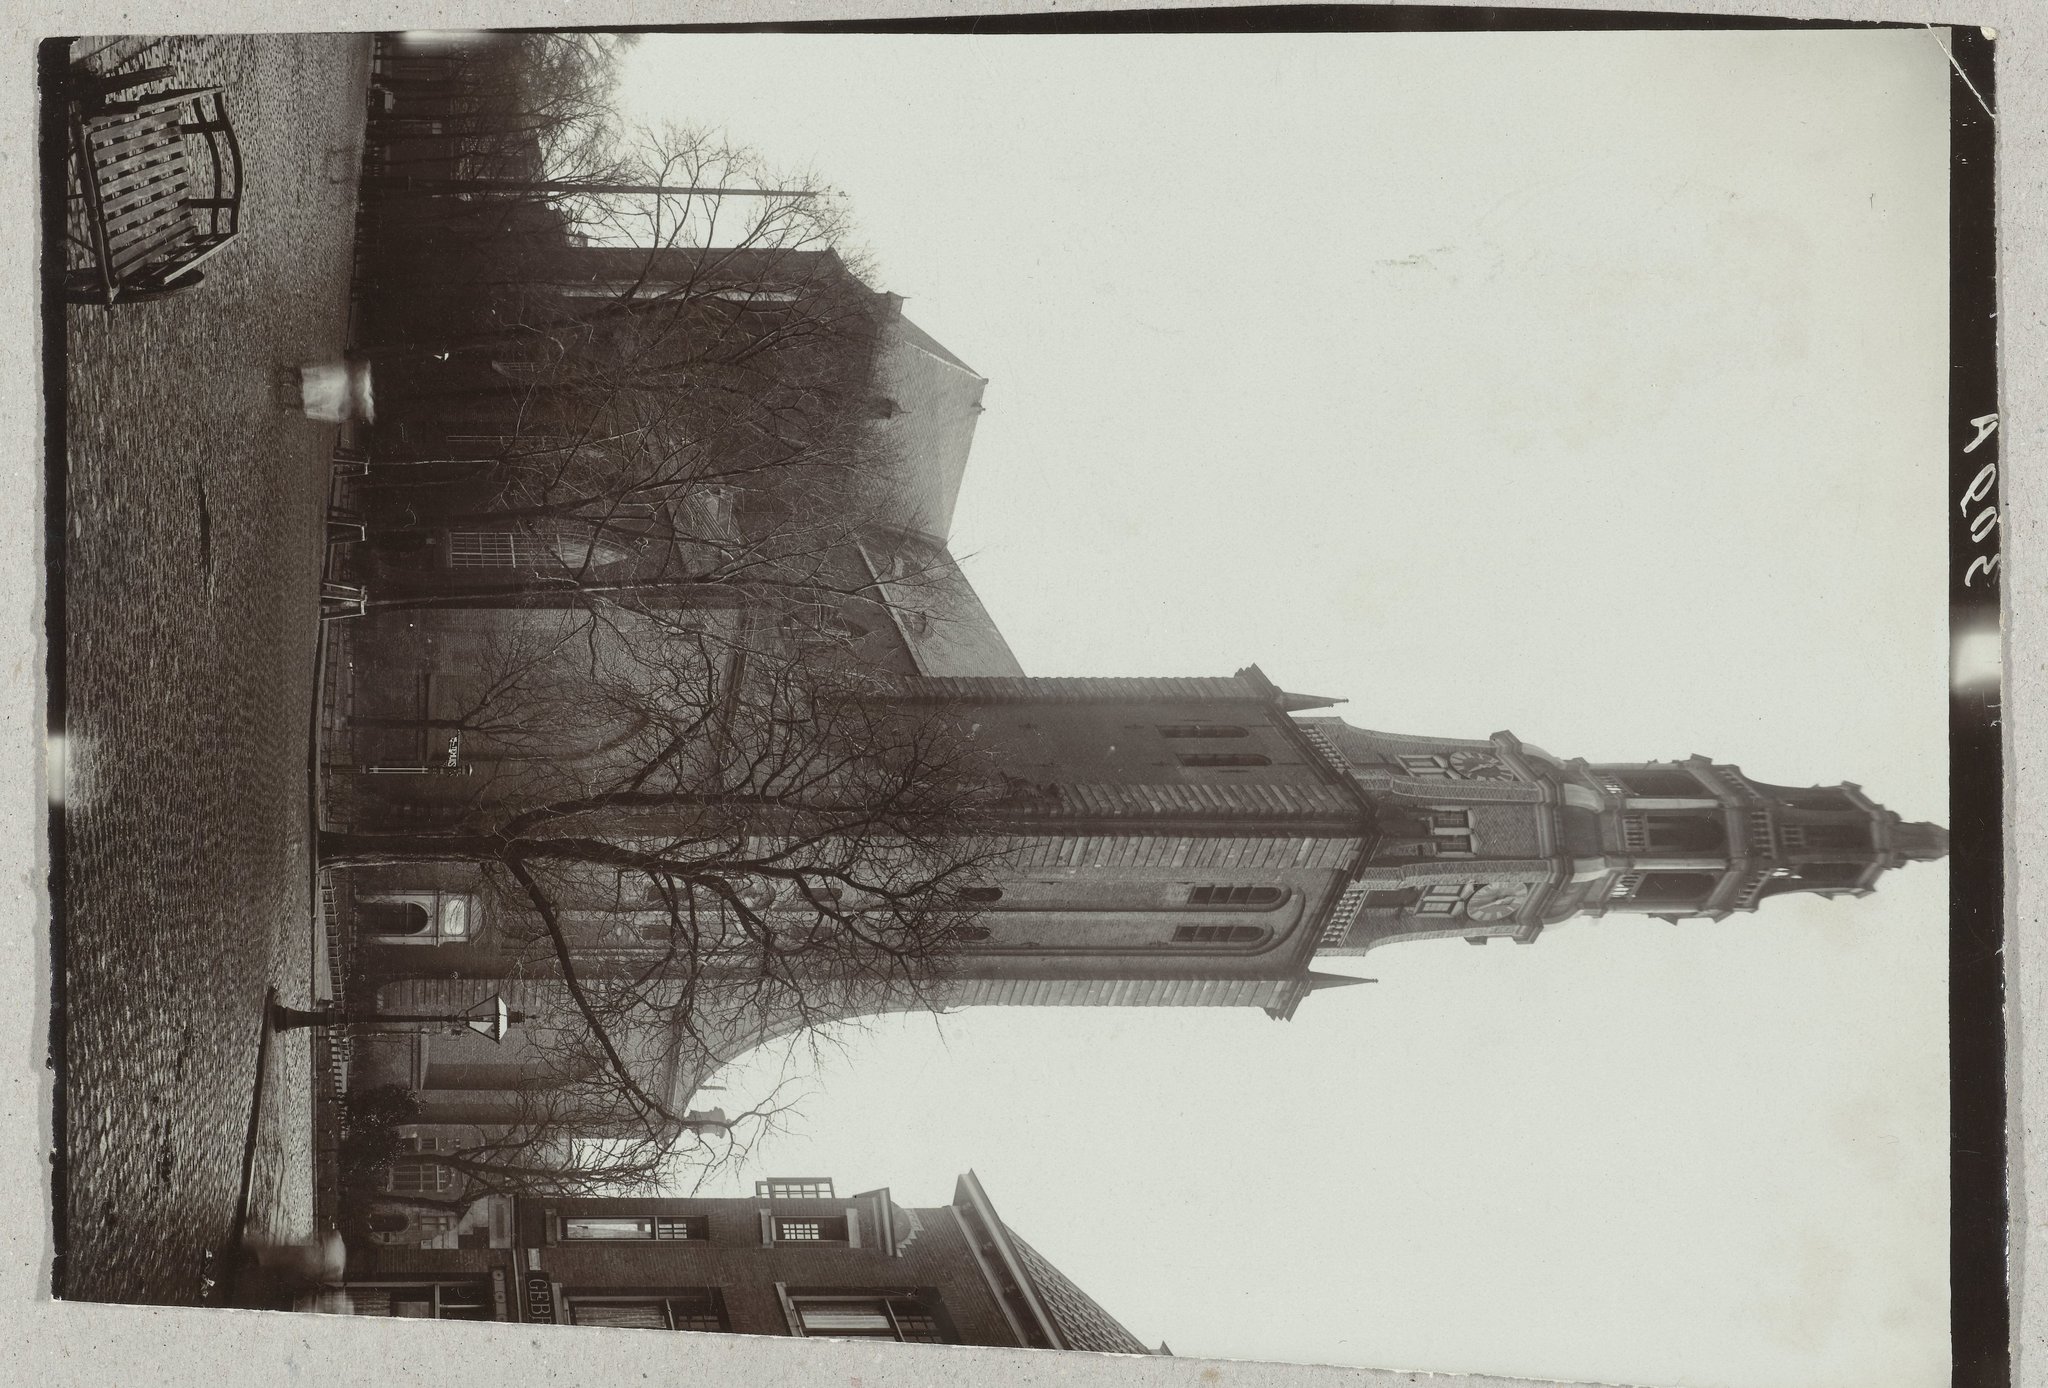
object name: cabinet photograph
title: Toren van de A-kerk in Groningen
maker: Anonymous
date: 1890-1925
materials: paper, photographic support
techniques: gelatin silver print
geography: netherlands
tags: parts of church exterior and annexes: tower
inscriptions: negative number: ‘309 A [in spiegelbeeld]’, annotation: ‘toren A-Kerk / Groningen’